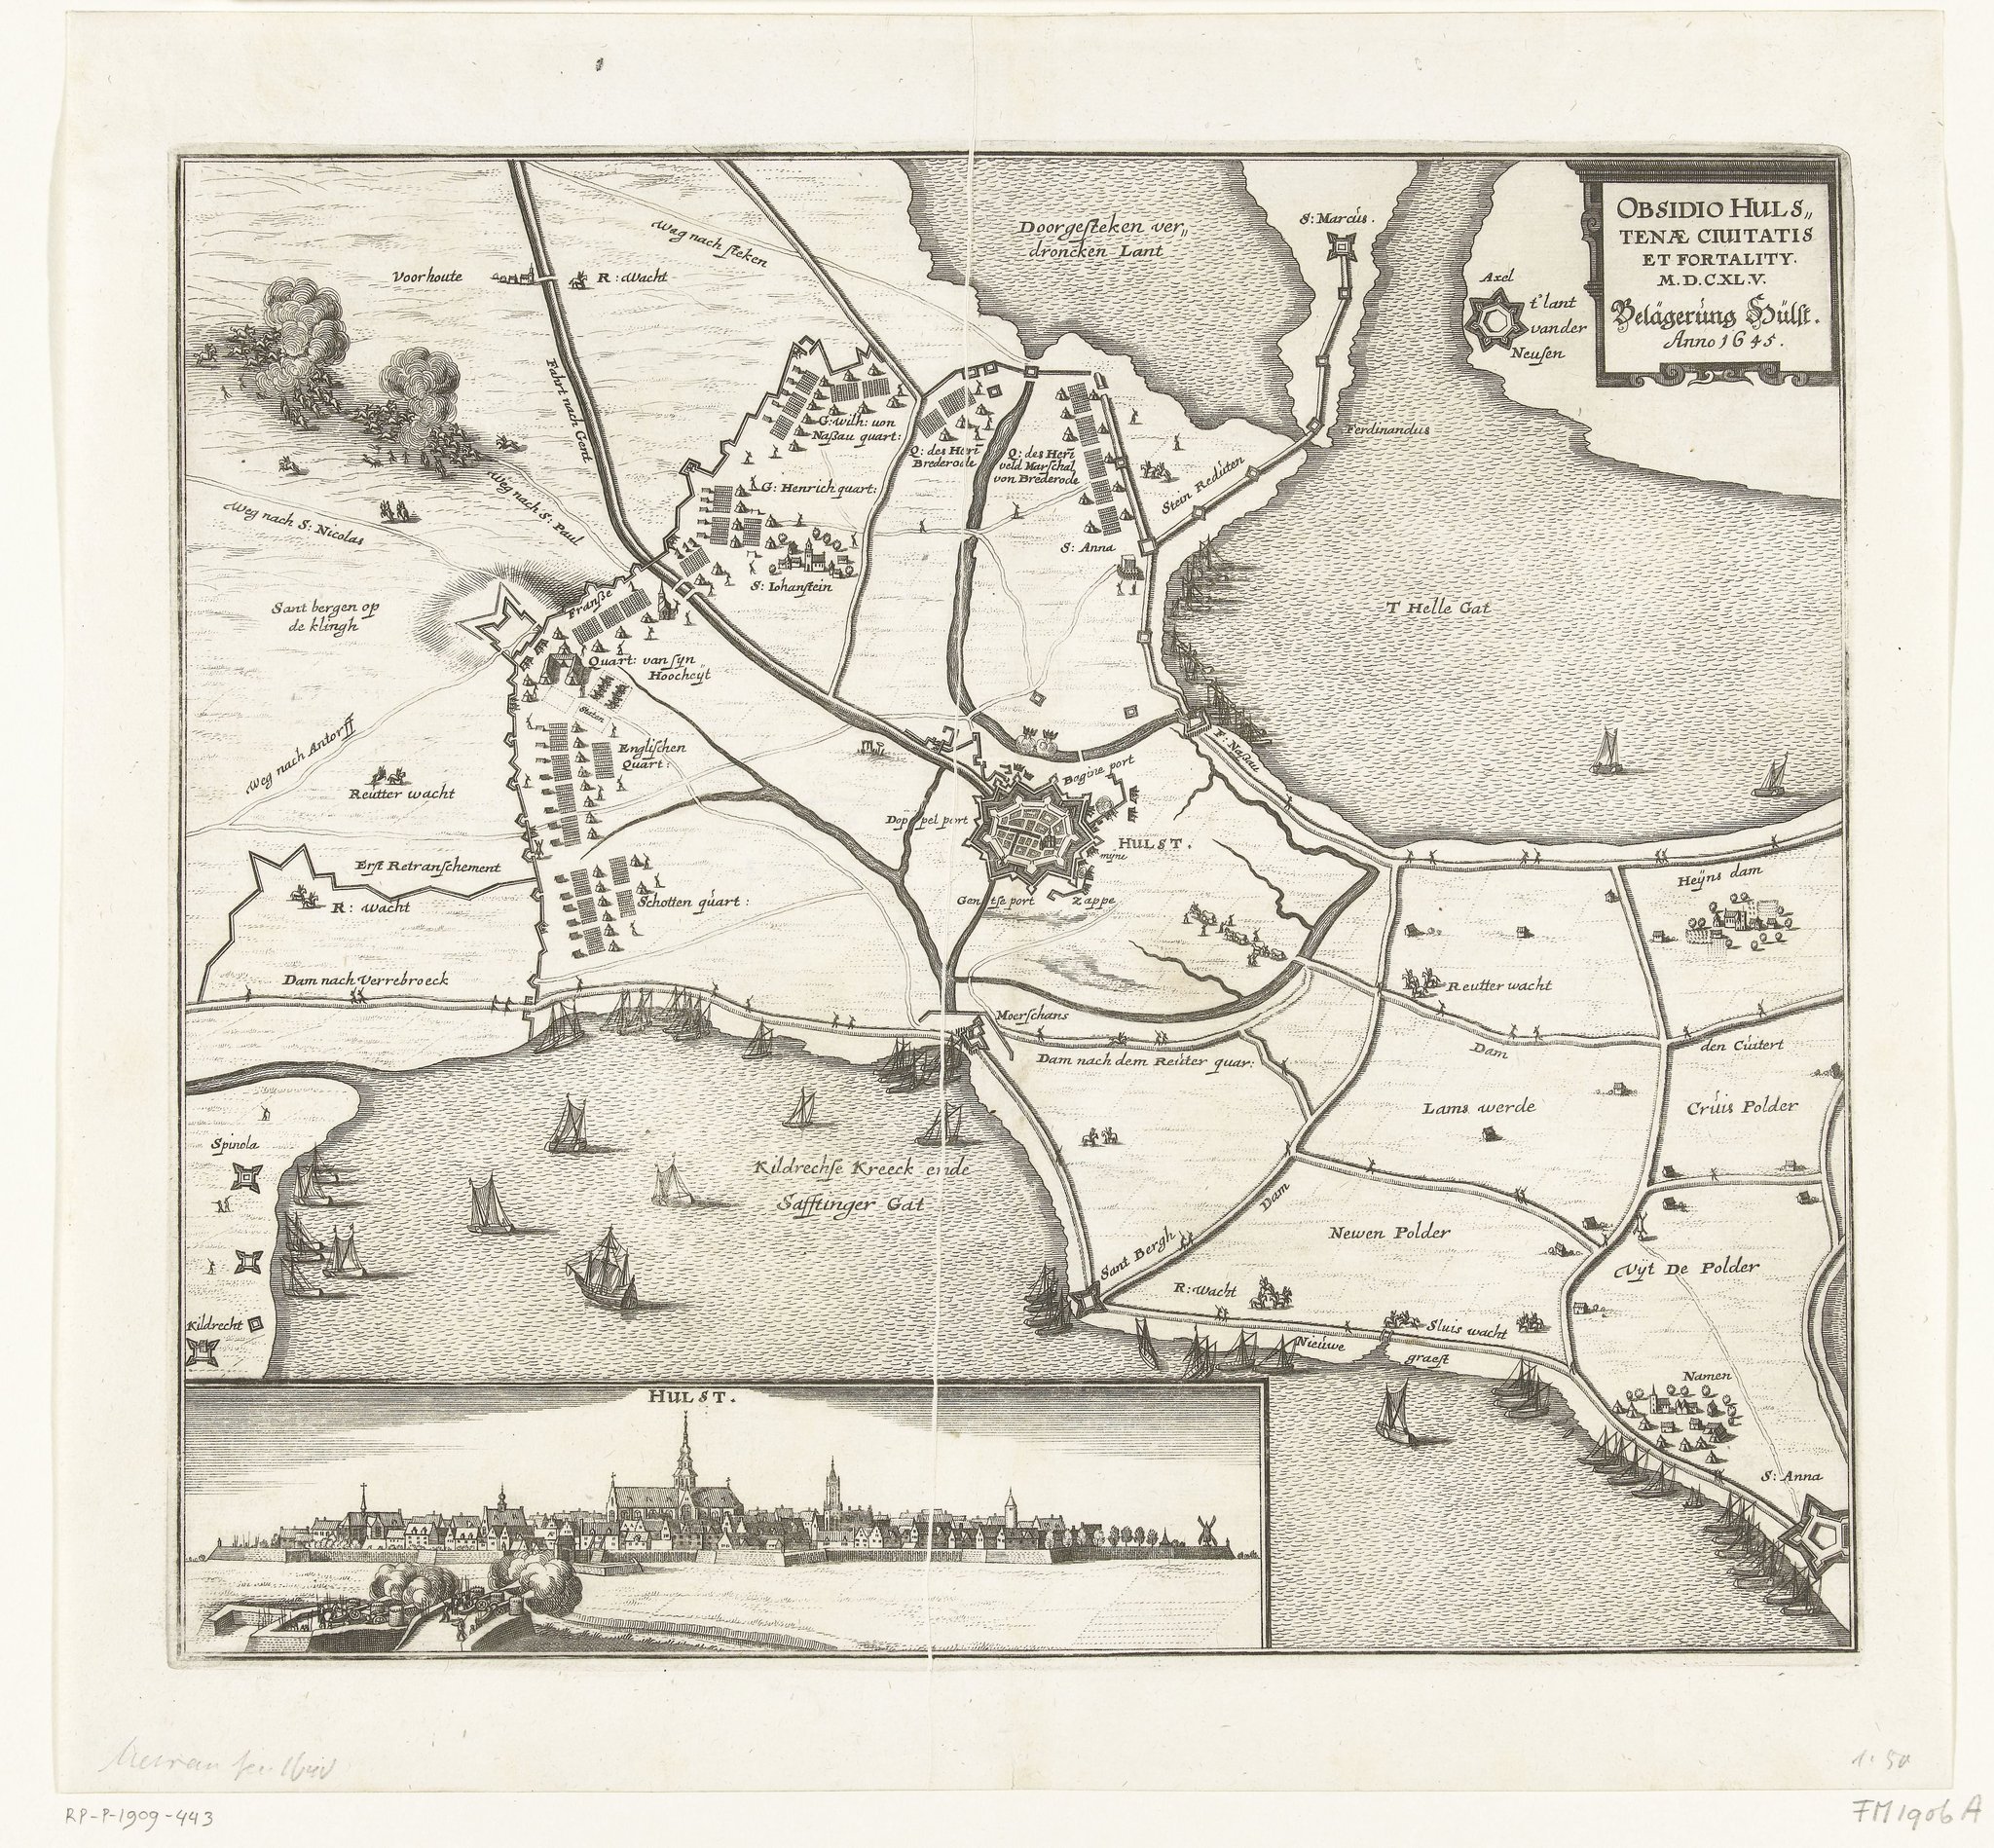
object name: print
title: Beleg van Hulst, 1645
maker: Anonymous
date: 1645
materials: paper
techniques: etching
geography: germany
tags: delft, the hague, frederick henry (prince of orange), maps of separate countries or regions, siege, position war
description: Beleg en verovering van Hulst door het Staatse leger onder Frederik Hendrik van 28 september tot 5 november 1645. Plan van de stad Hulst en het omliggende land met de omsingeling en de legerkampen van de belegeraars. Linksonder een profiel van de stad.